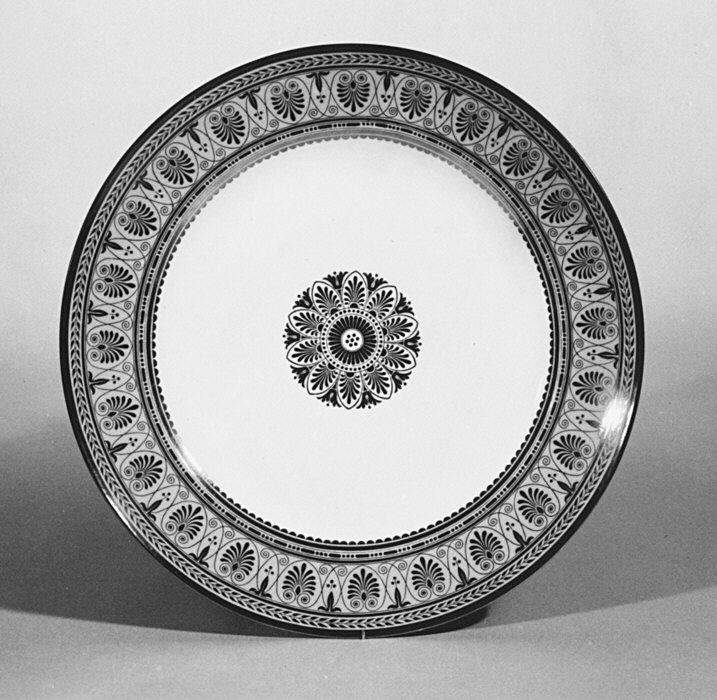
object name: plate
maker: sèvres manufactory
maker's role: manufactory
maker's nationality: french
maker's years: 1740-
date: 1837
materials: hard paste porcelain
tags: flowers